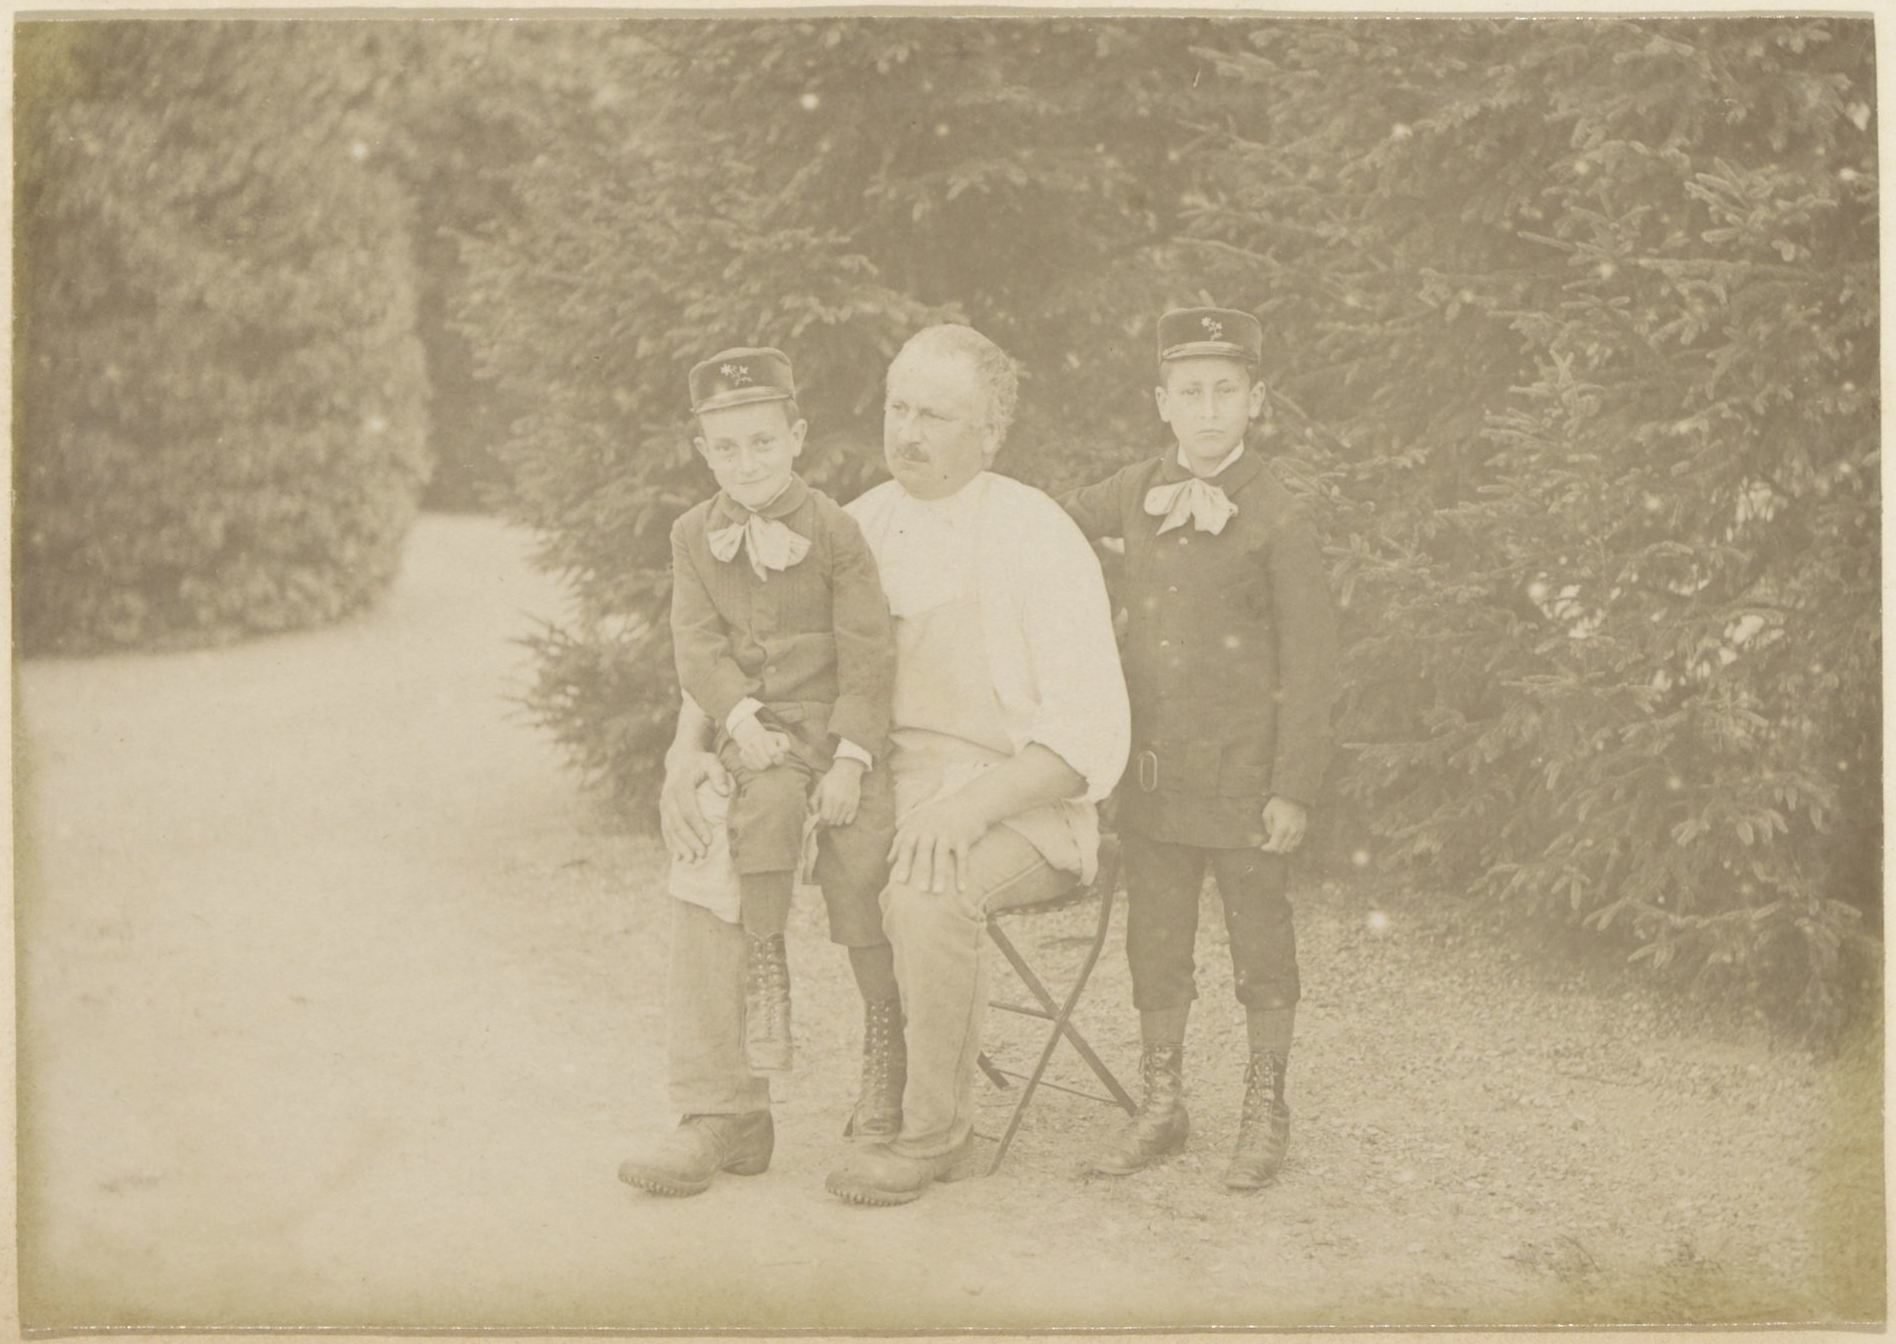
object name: photograph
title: Portret van een man en twee jongens in een tuin in Frankrijk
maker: Anonymous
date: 1900-1910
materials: paper, photographic support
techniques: albumen print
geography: france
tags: father and child(ren), man and child(ren) (family group), france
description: Onderdeel van Fotoalbum van een Franse amateurfotograaf met opnames van een familie, distilleerderij Delizy & Doistau Fils, het leger en bezienswaardigheden in Frankrijk.